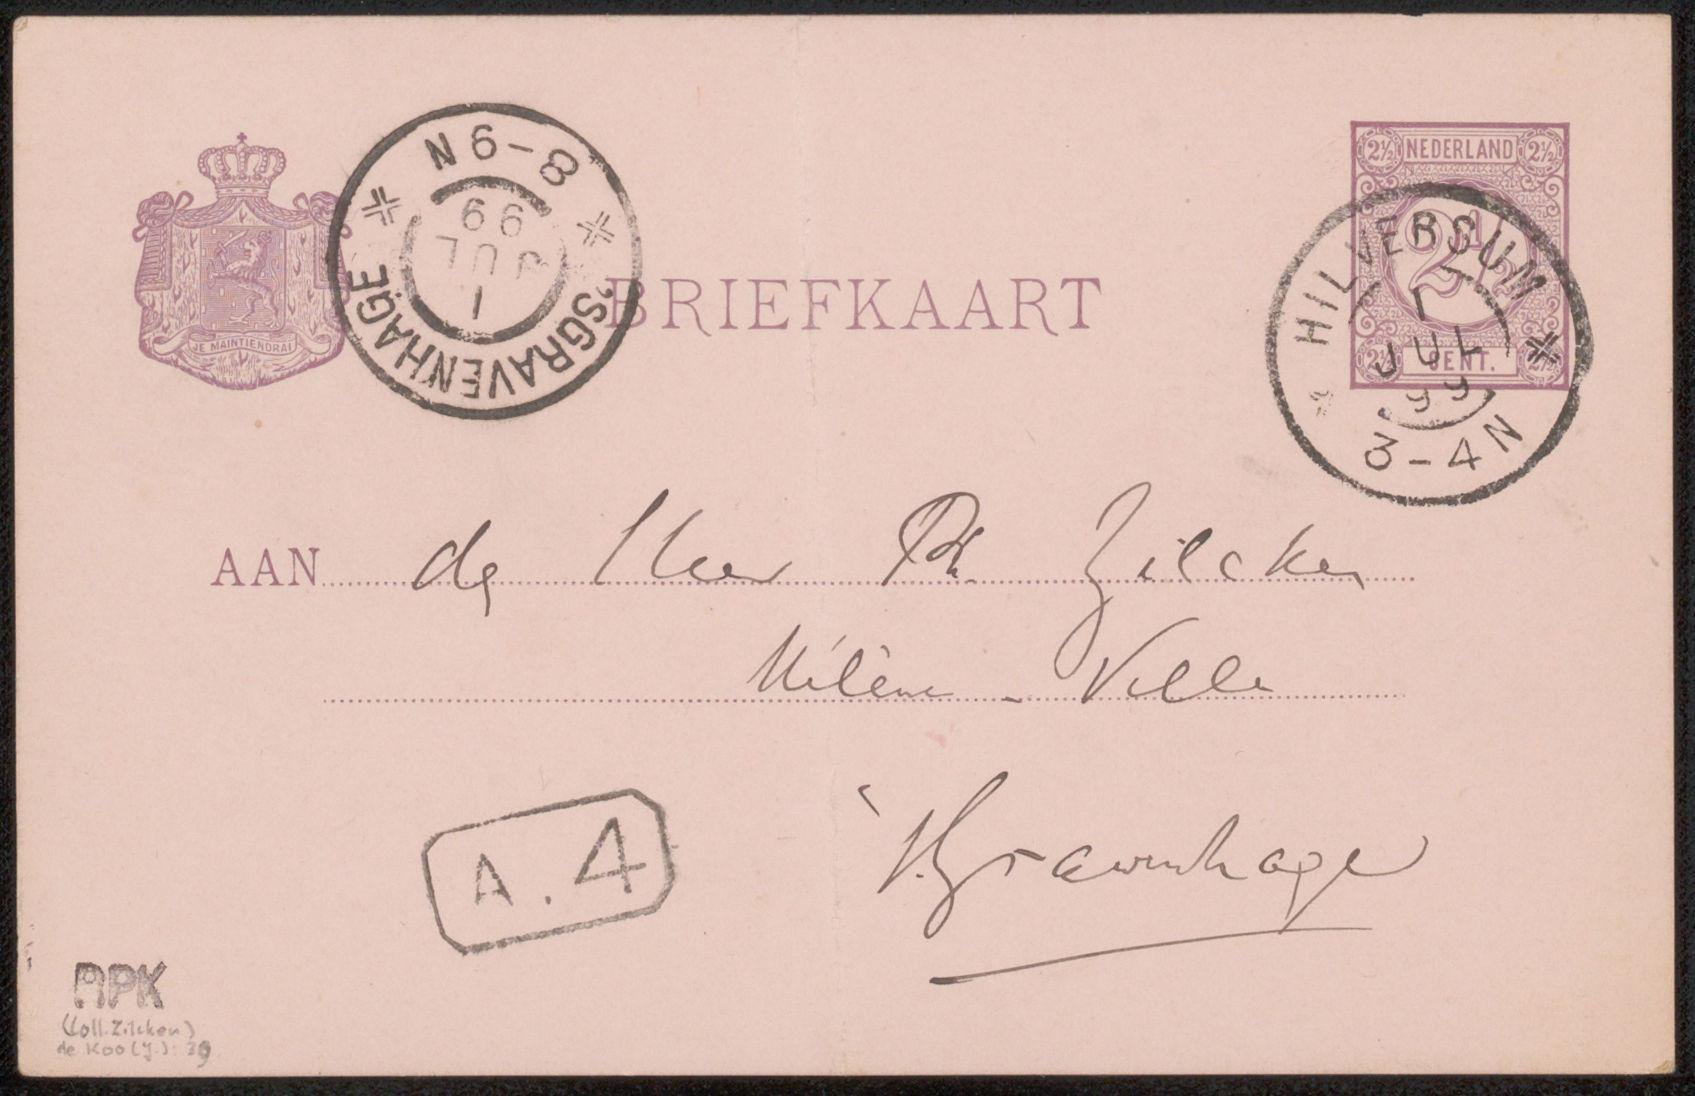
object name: postcard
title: Briefkaart aan Philip Zilcken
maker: johannes de koo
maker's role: auteur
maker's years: 1841-1909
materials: cardboard, ink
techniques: pen, writing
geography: hilversum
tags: dordrecht, ewaldus daniél pijzel, the hague, draughtsman, philip zilcken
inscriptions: collector's mark: ‘RPK’